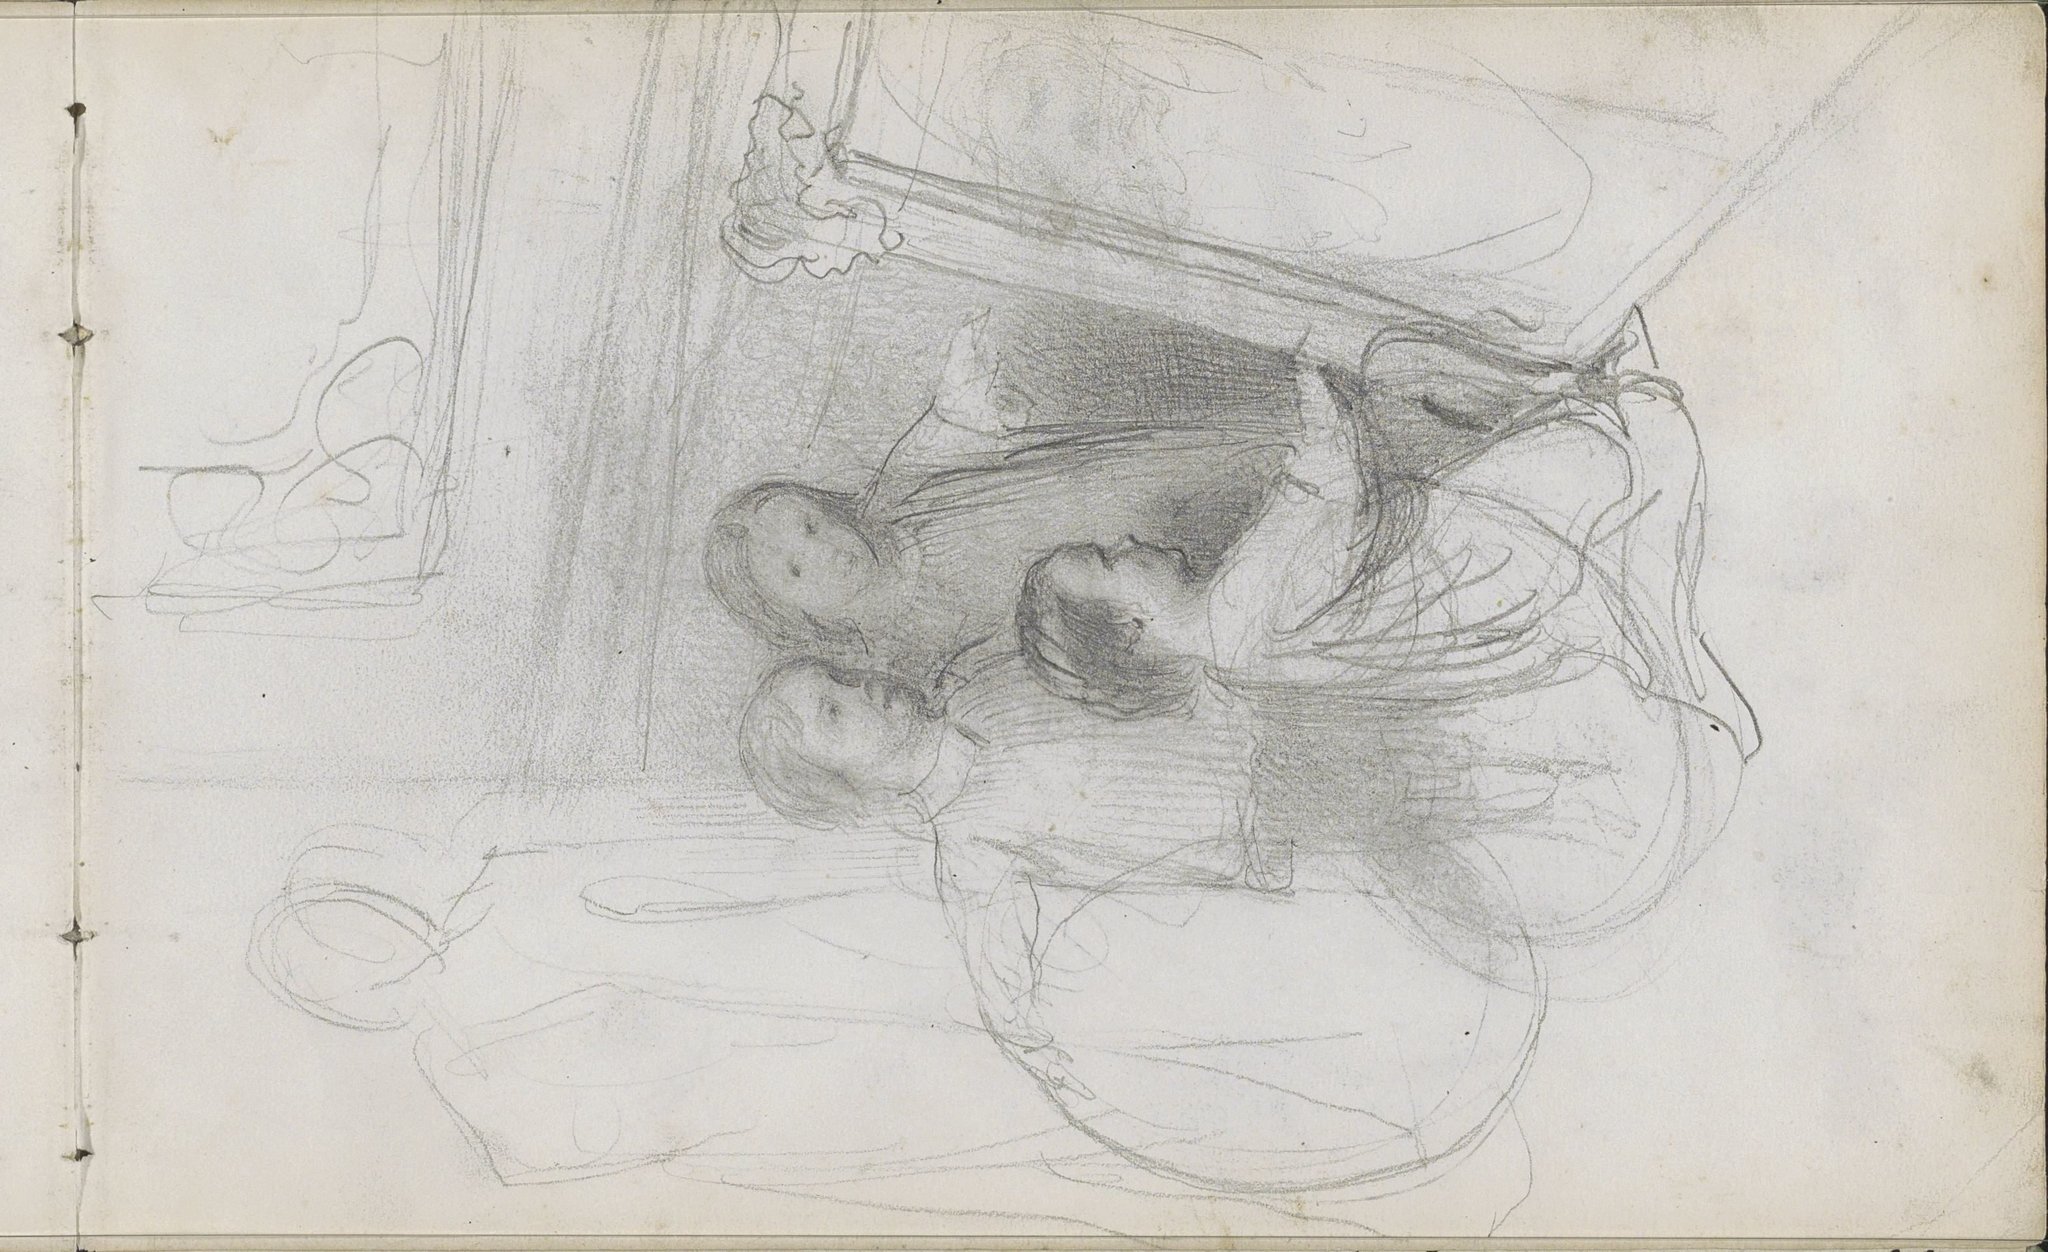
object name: sketchbook leaf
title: Drie kinderen bekijken een spiegel bij een schouw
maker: bastiaan de poorter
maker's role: painter, print maker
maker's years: 1813-1880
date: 1858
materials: paper, pencil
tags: mirror, child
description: Drie kinderen staan en zitten bij een schouw en kijken en wijzen naar een spiegel met ornamentele lijst. Op de achtergrond staat een vrouw. Blad 39 recto uit een gecombineerd album amicorum en schetsboek met in totaal 39 bladen.